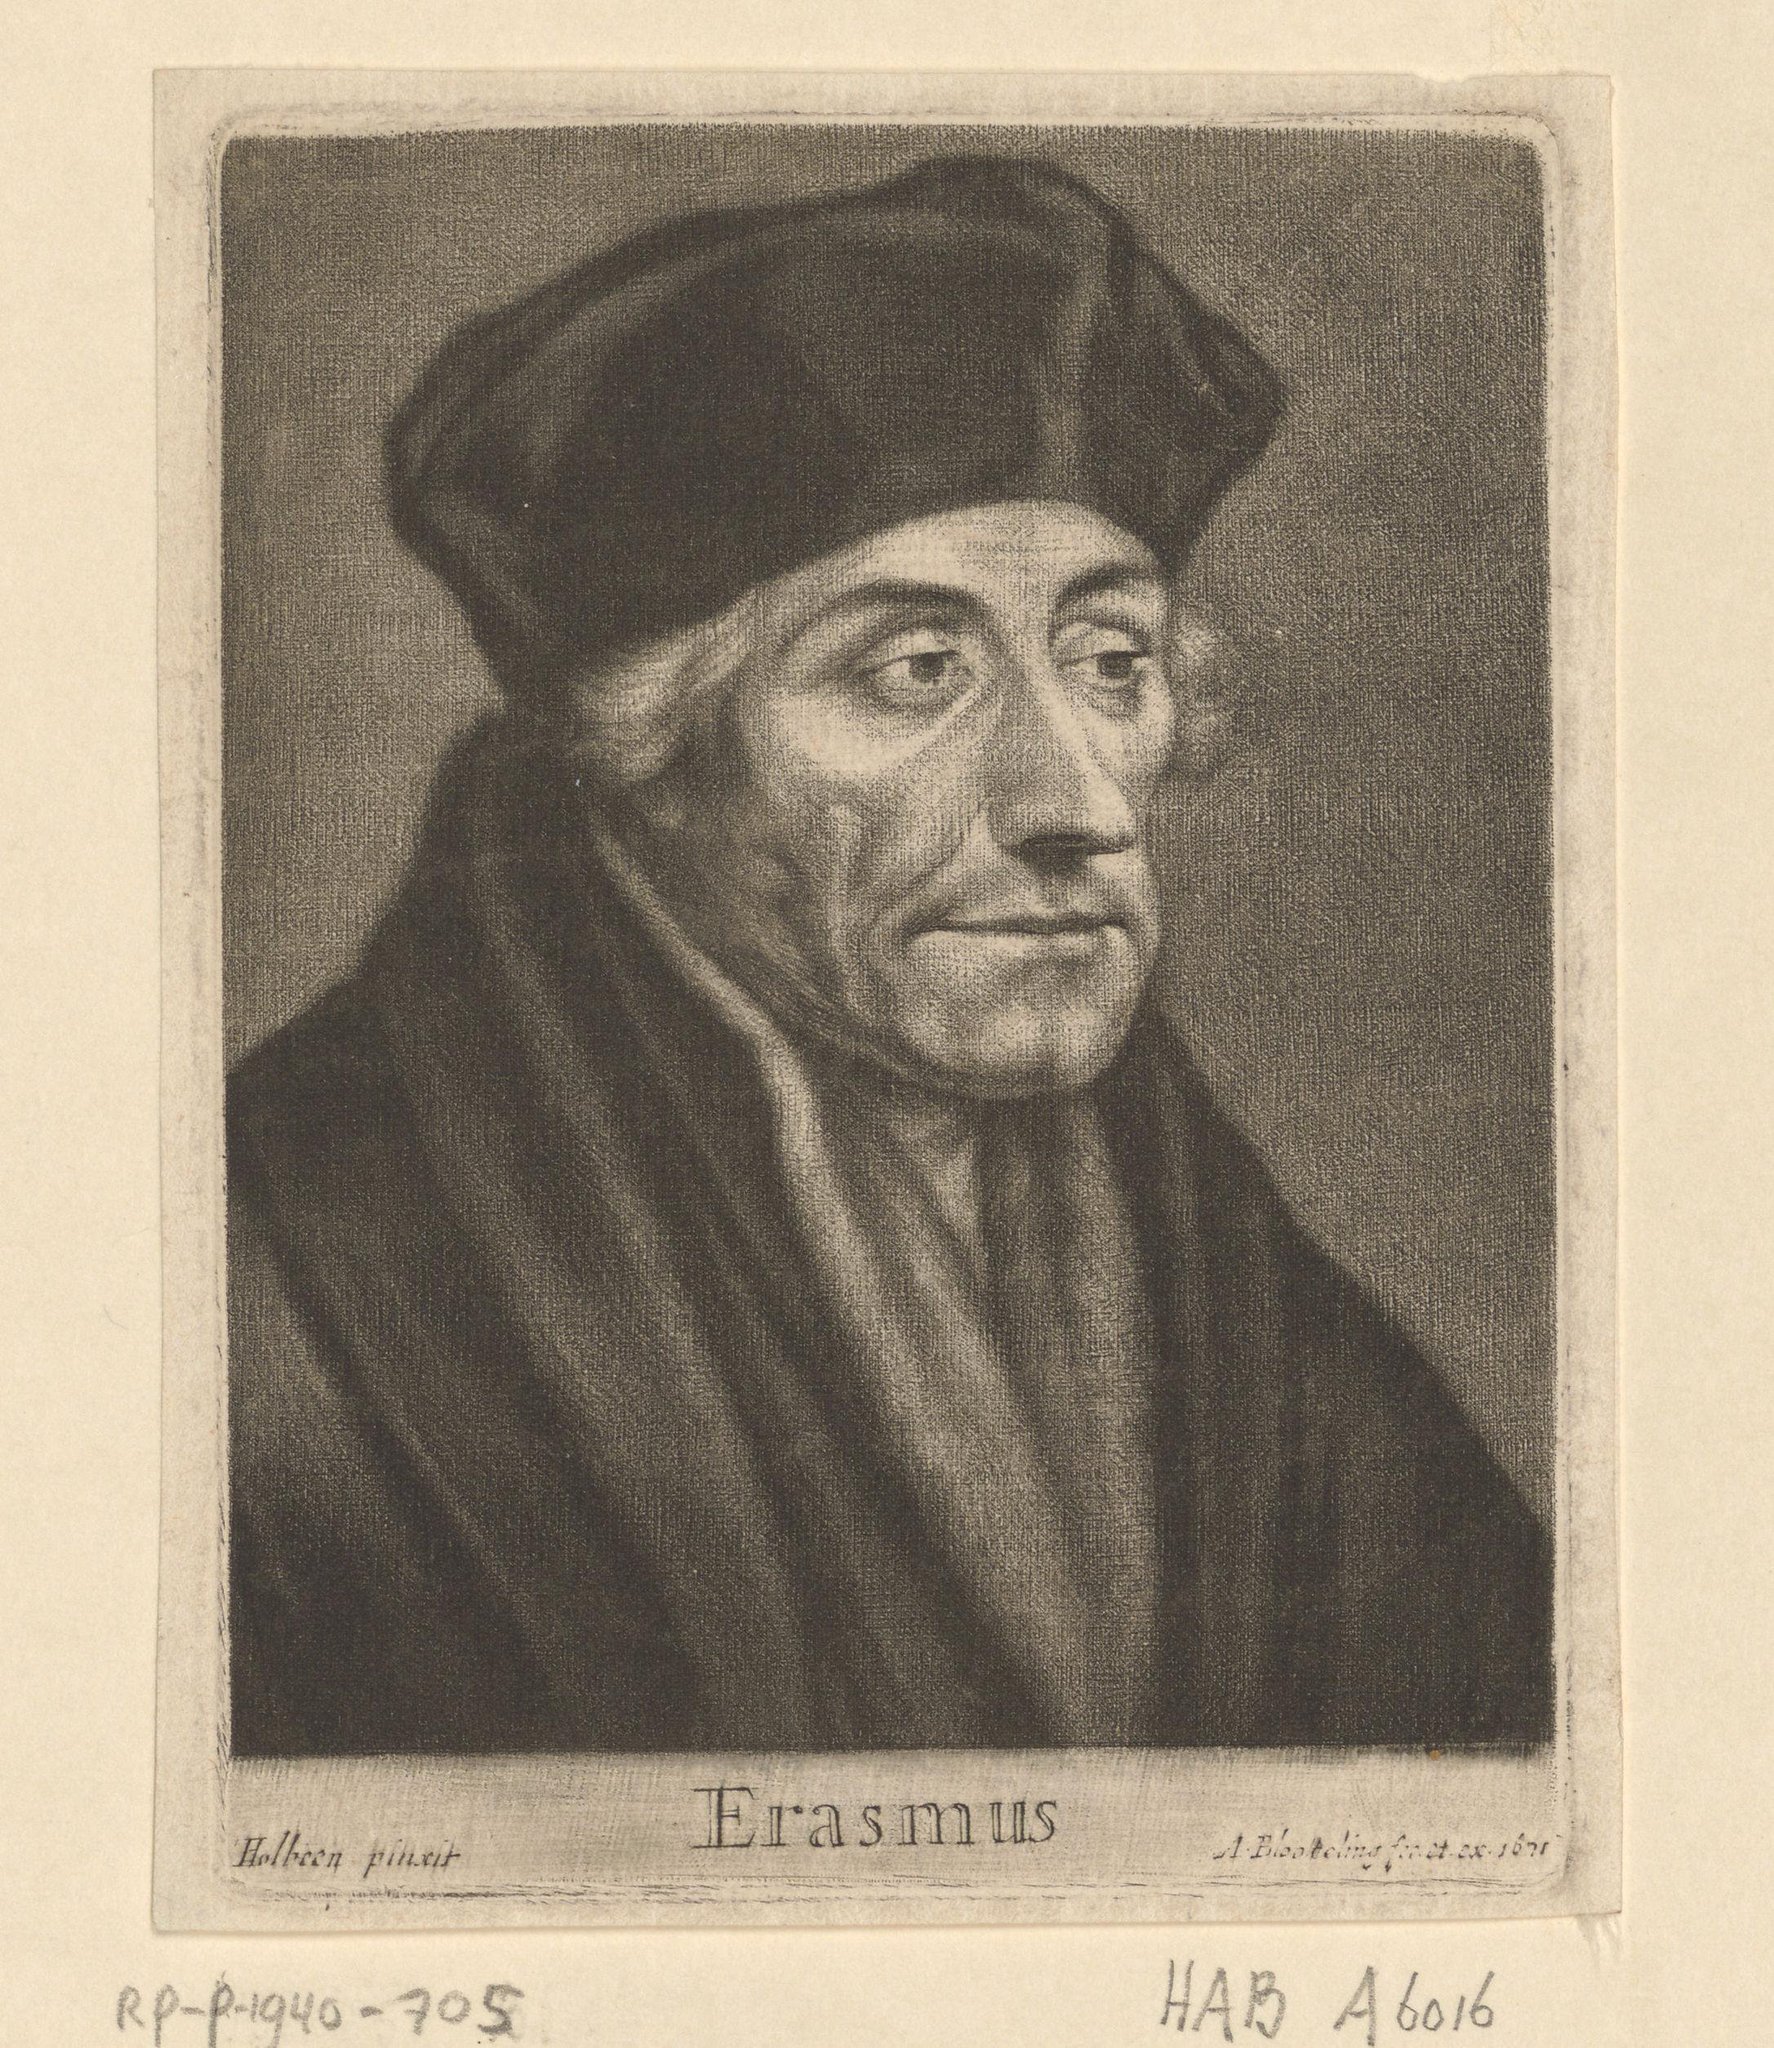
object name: print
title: Portret van Desiderius Erasmus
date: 1671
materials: paper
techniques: engraving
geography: amsterdam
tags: rotterdam, desiderius erasmus, historical persons, scholar, philosopher (+ portrait of scholar, scientist)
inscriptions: collector's mark: Lugt 2760, collector's mark: Lugt 2228